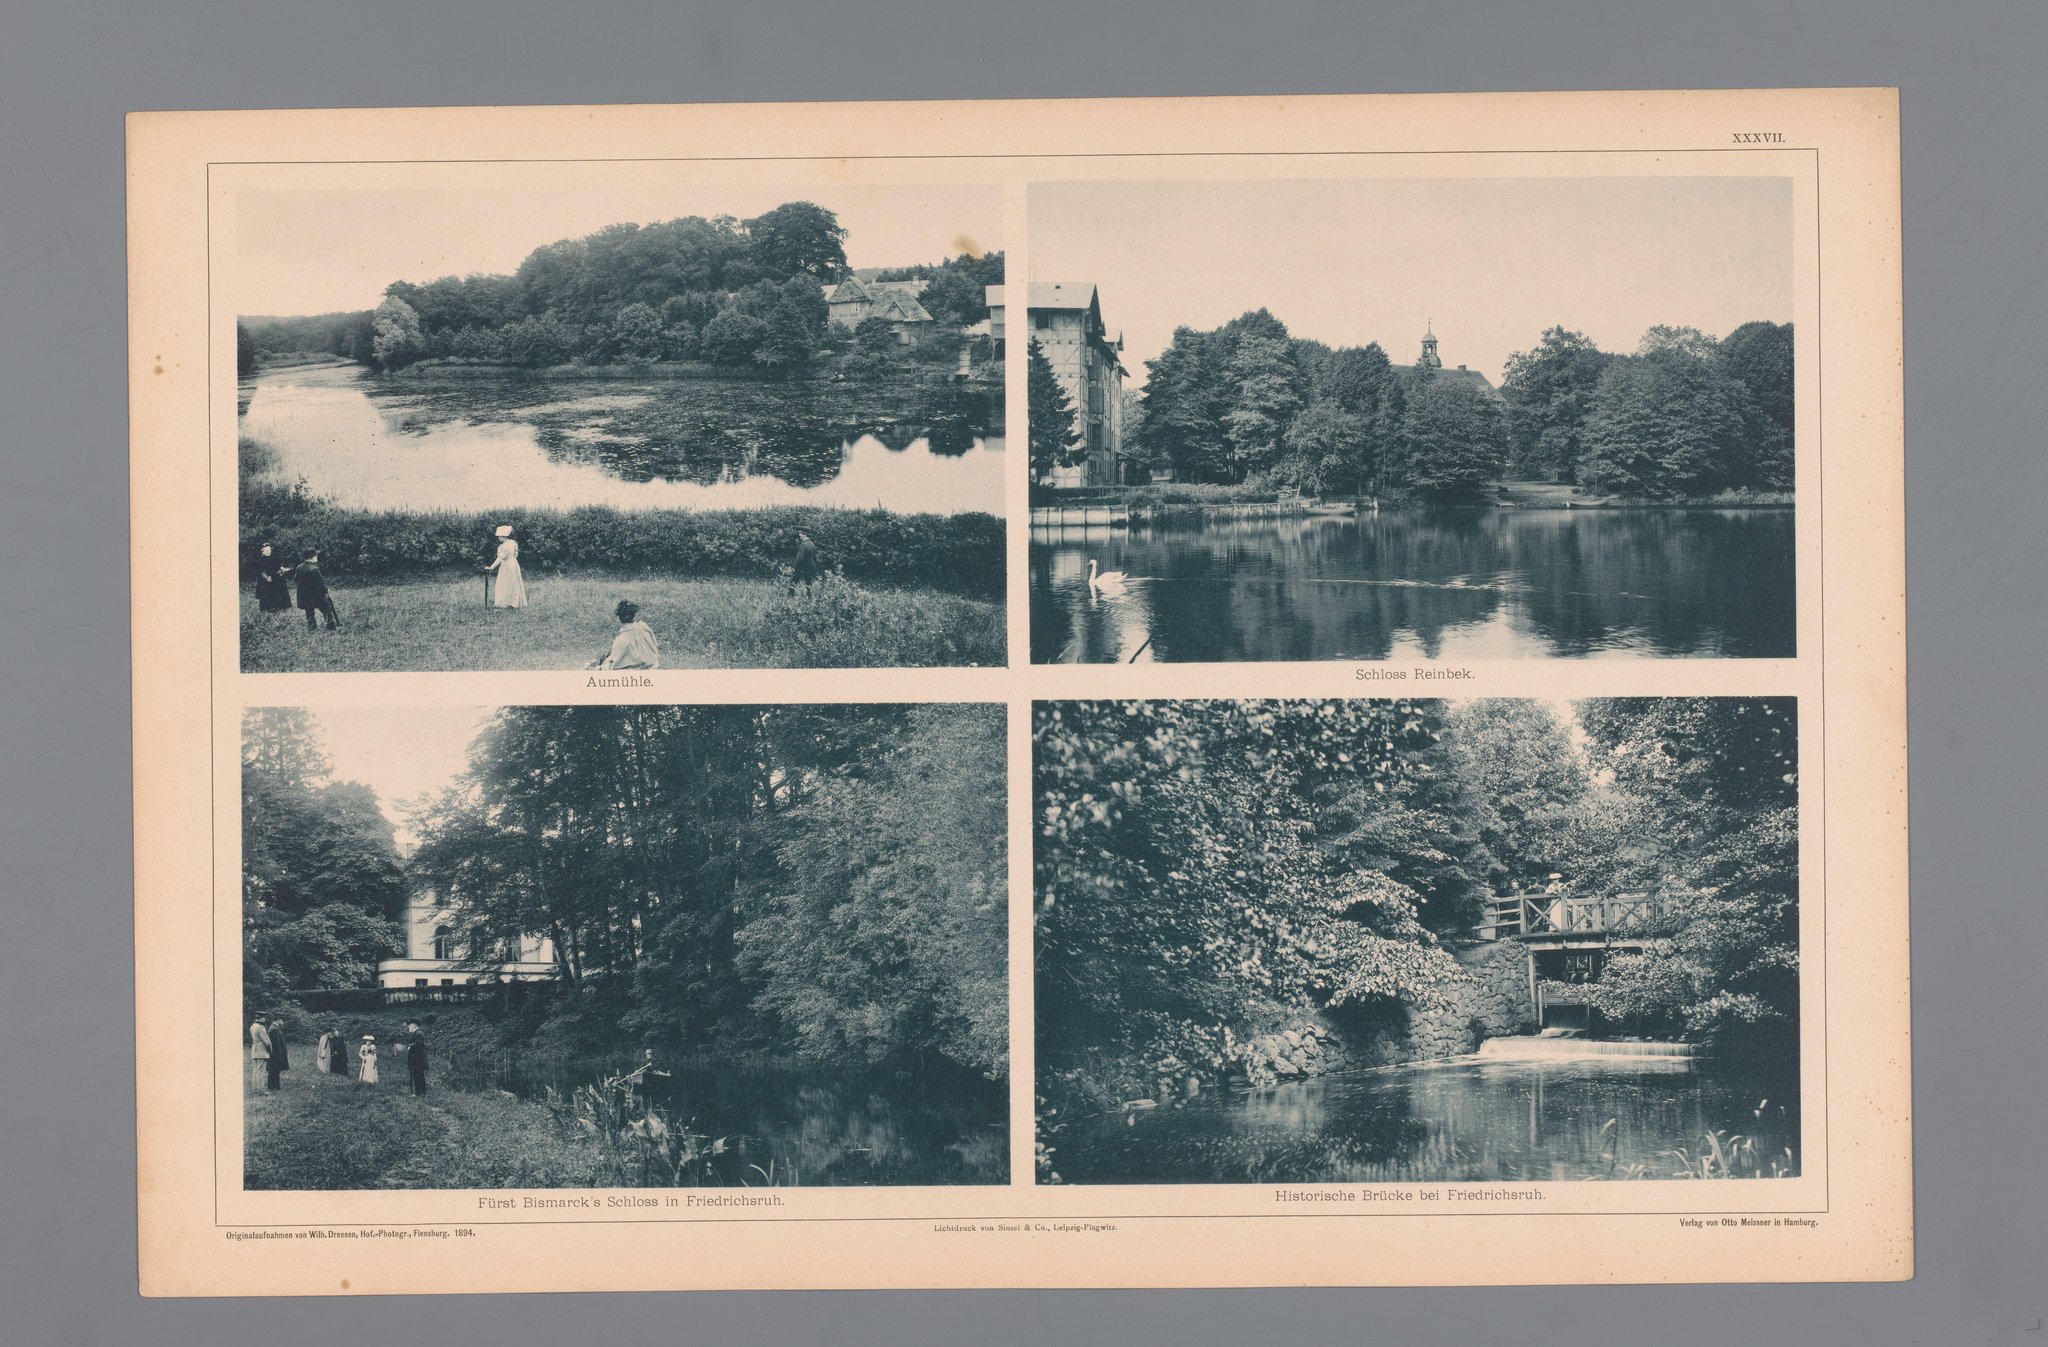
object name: photomechanical print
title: Historische Brücke bei Friedrichsruh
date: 1894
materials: paper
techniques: photograph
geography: leipzig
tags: castle, brook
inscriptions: inscription: ‘Originalaufnahmen von Wilh. Dreesen, Hof.-Photogr., Flensburg. 1894.’, number: ‘XXXVII.’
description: Deze prenten maken deel uit van een omslag met 126 prenten op 37 bladen en een tekstblad.